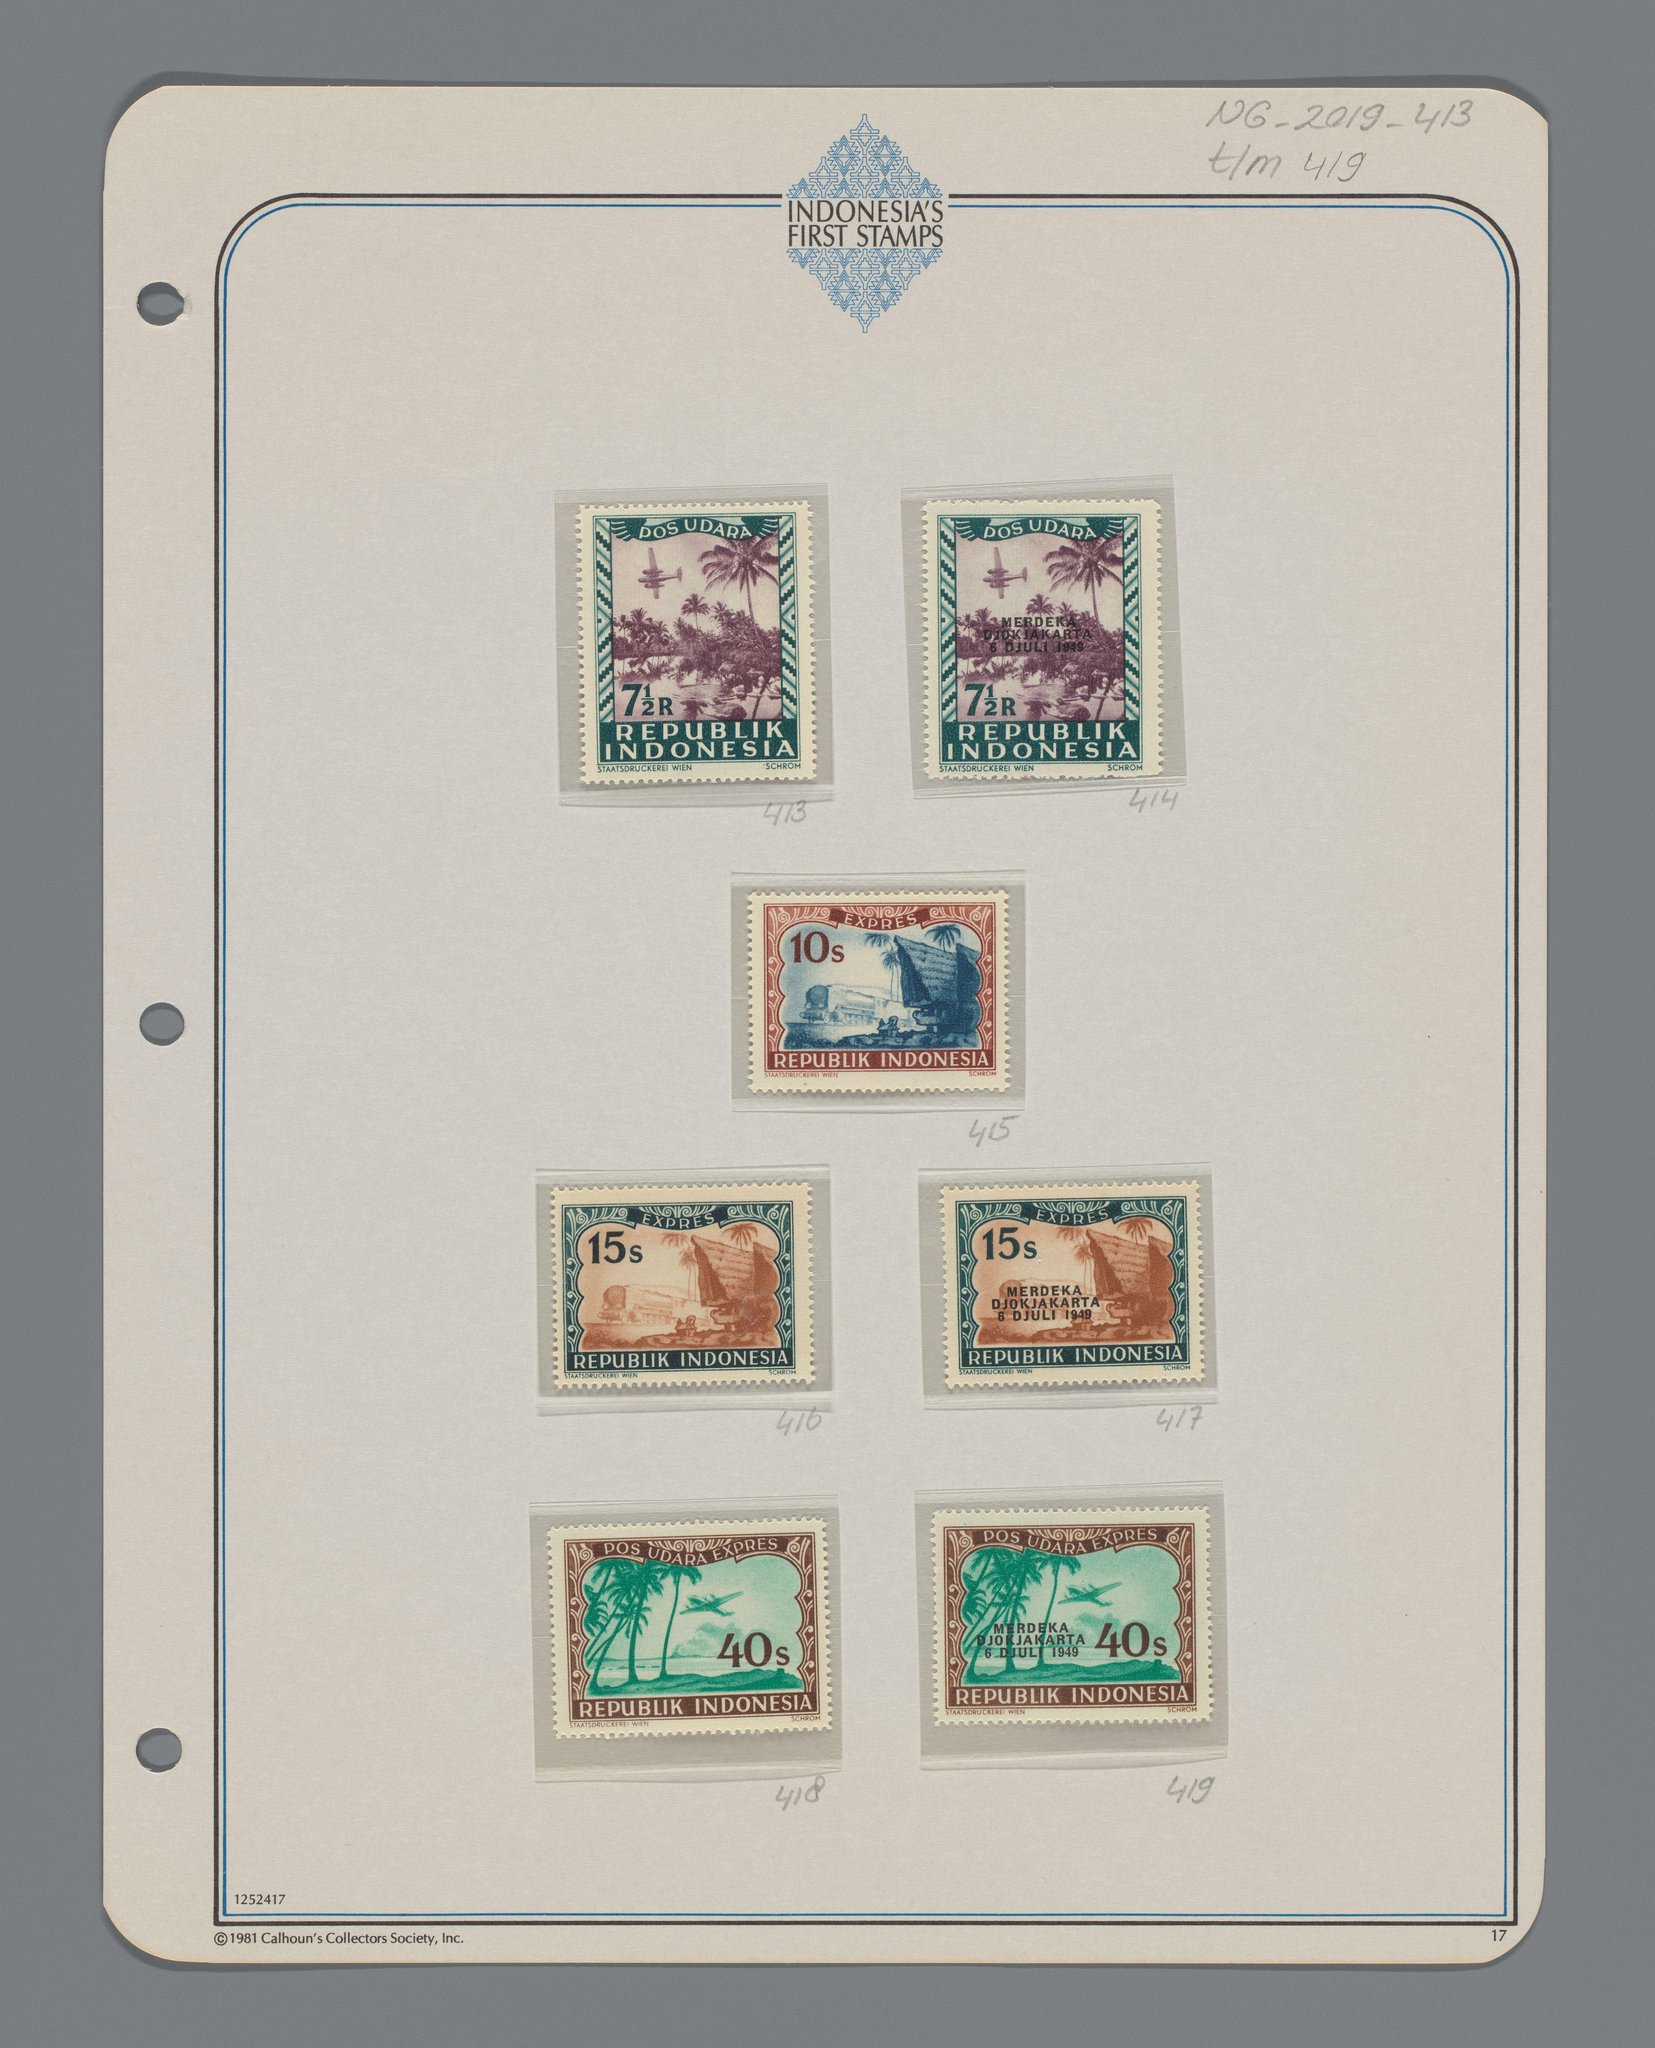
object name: postage stamp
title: Postzegel Republik Indonesia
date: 1949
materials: paper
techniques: photoaquatint, engraving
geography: vienna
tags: indonesia